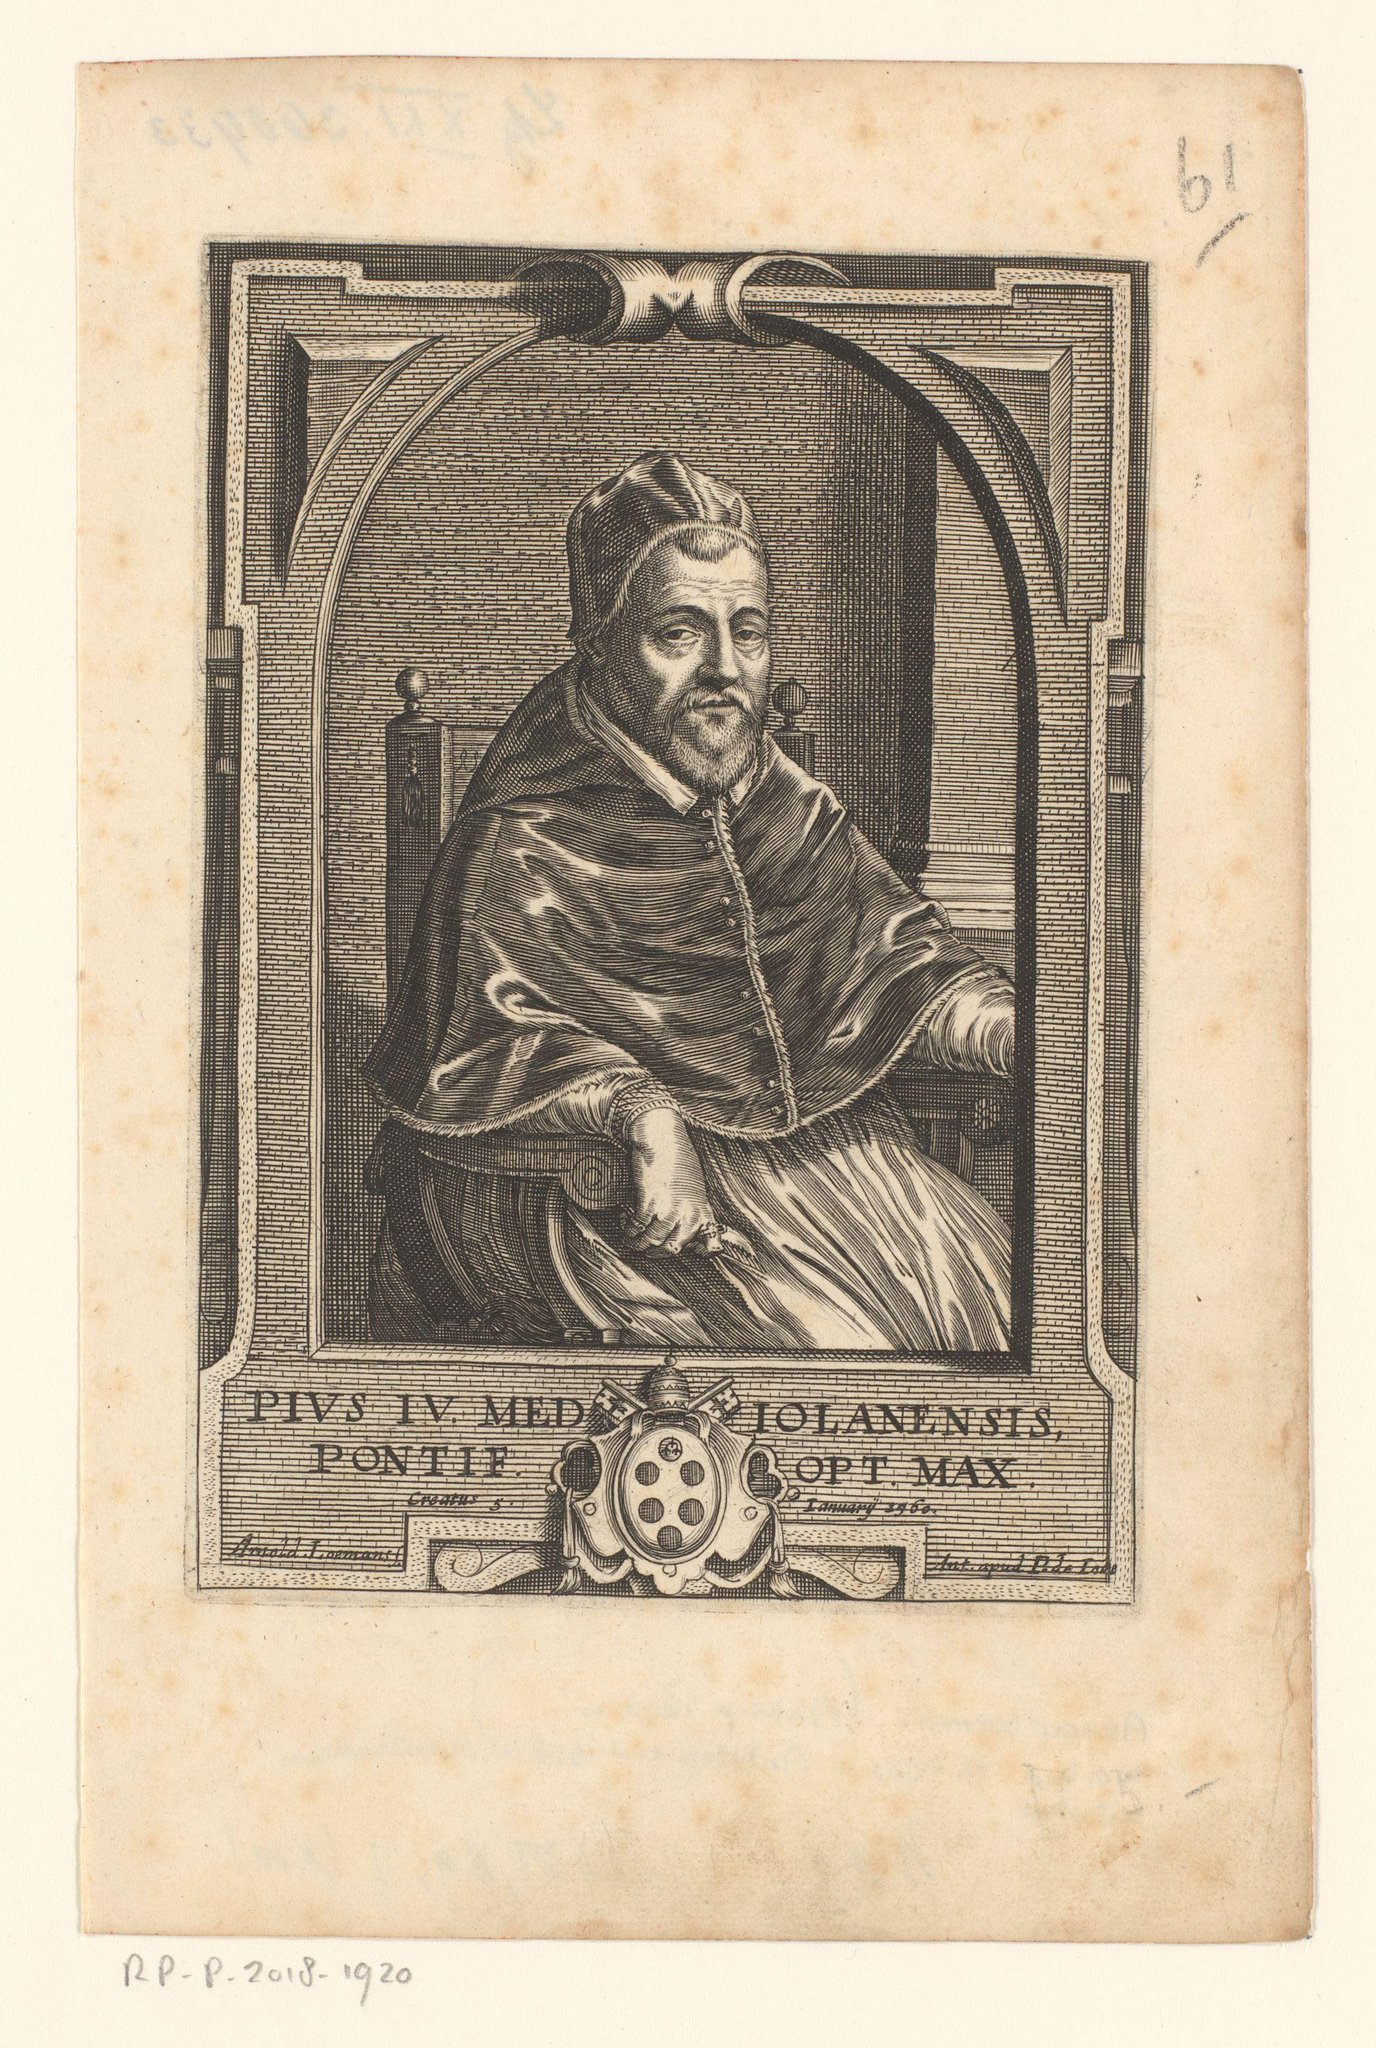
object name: print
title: Portret van paus Pius IV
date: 1632-1670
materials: paper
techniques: engraving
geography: antwerp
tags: rome, pius iv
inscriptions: collector's mark: Lugt 2228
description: Portret van paus Pius IV, met zijn pauselijk wapen.